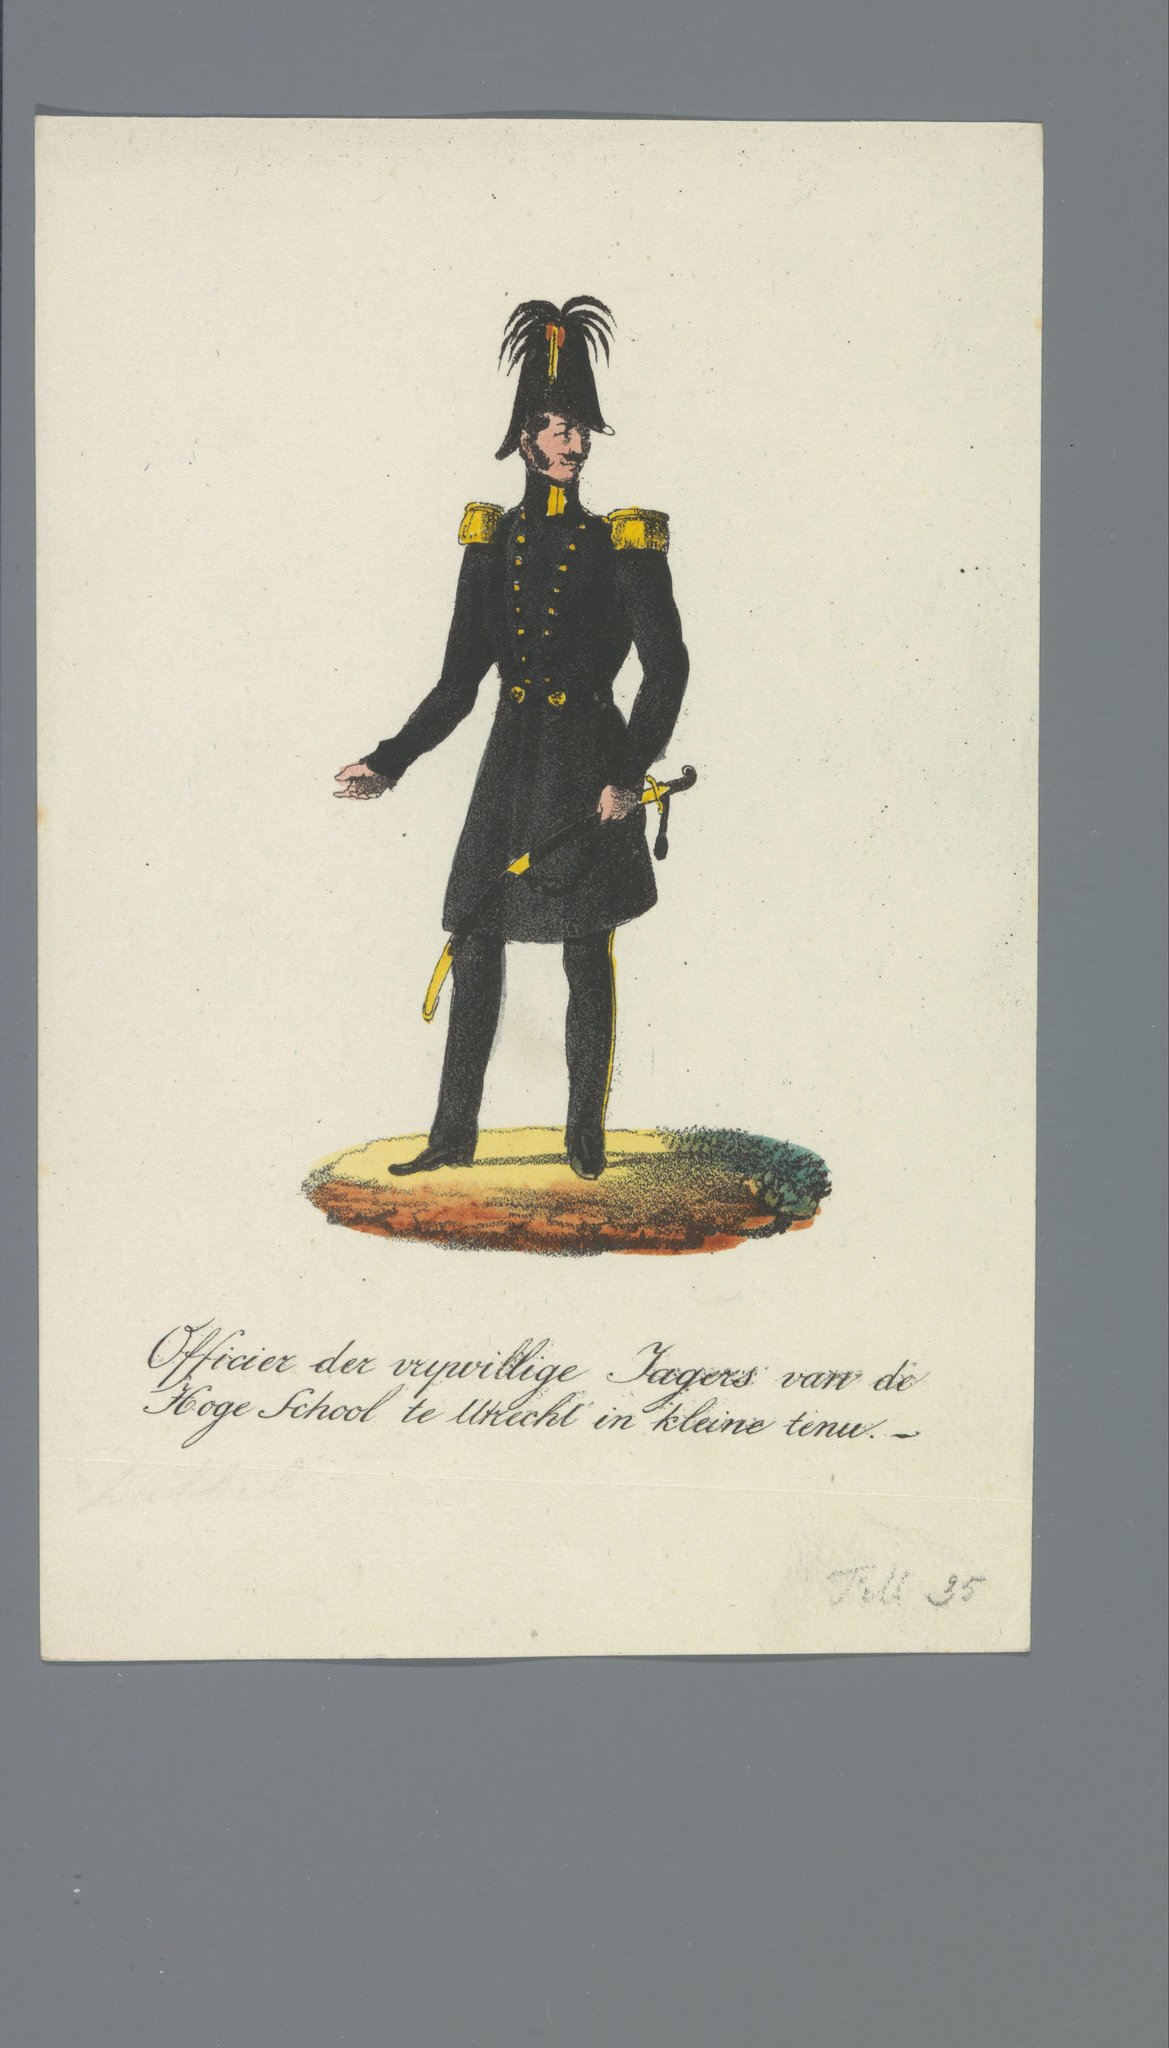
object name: costume print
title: Nederlandse militaire uniformen in de jaren 1830-1832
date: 1835-1850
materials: paper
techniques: hand coloring, lithograph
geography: netherlands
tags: (military) uniforms, clothes, costume, utrecht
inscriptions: collector's mark: Lugt 2227, collector's mark: Lugt 2228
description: Staande officier van de Compagnie Vrijwillige Jagers van de Hogeschool te Utrecht, in kleine tenue. Onderdeel van een serie van 157 losse bladen met Nederlandse militaire uniformen in de jaren 1830-1832.